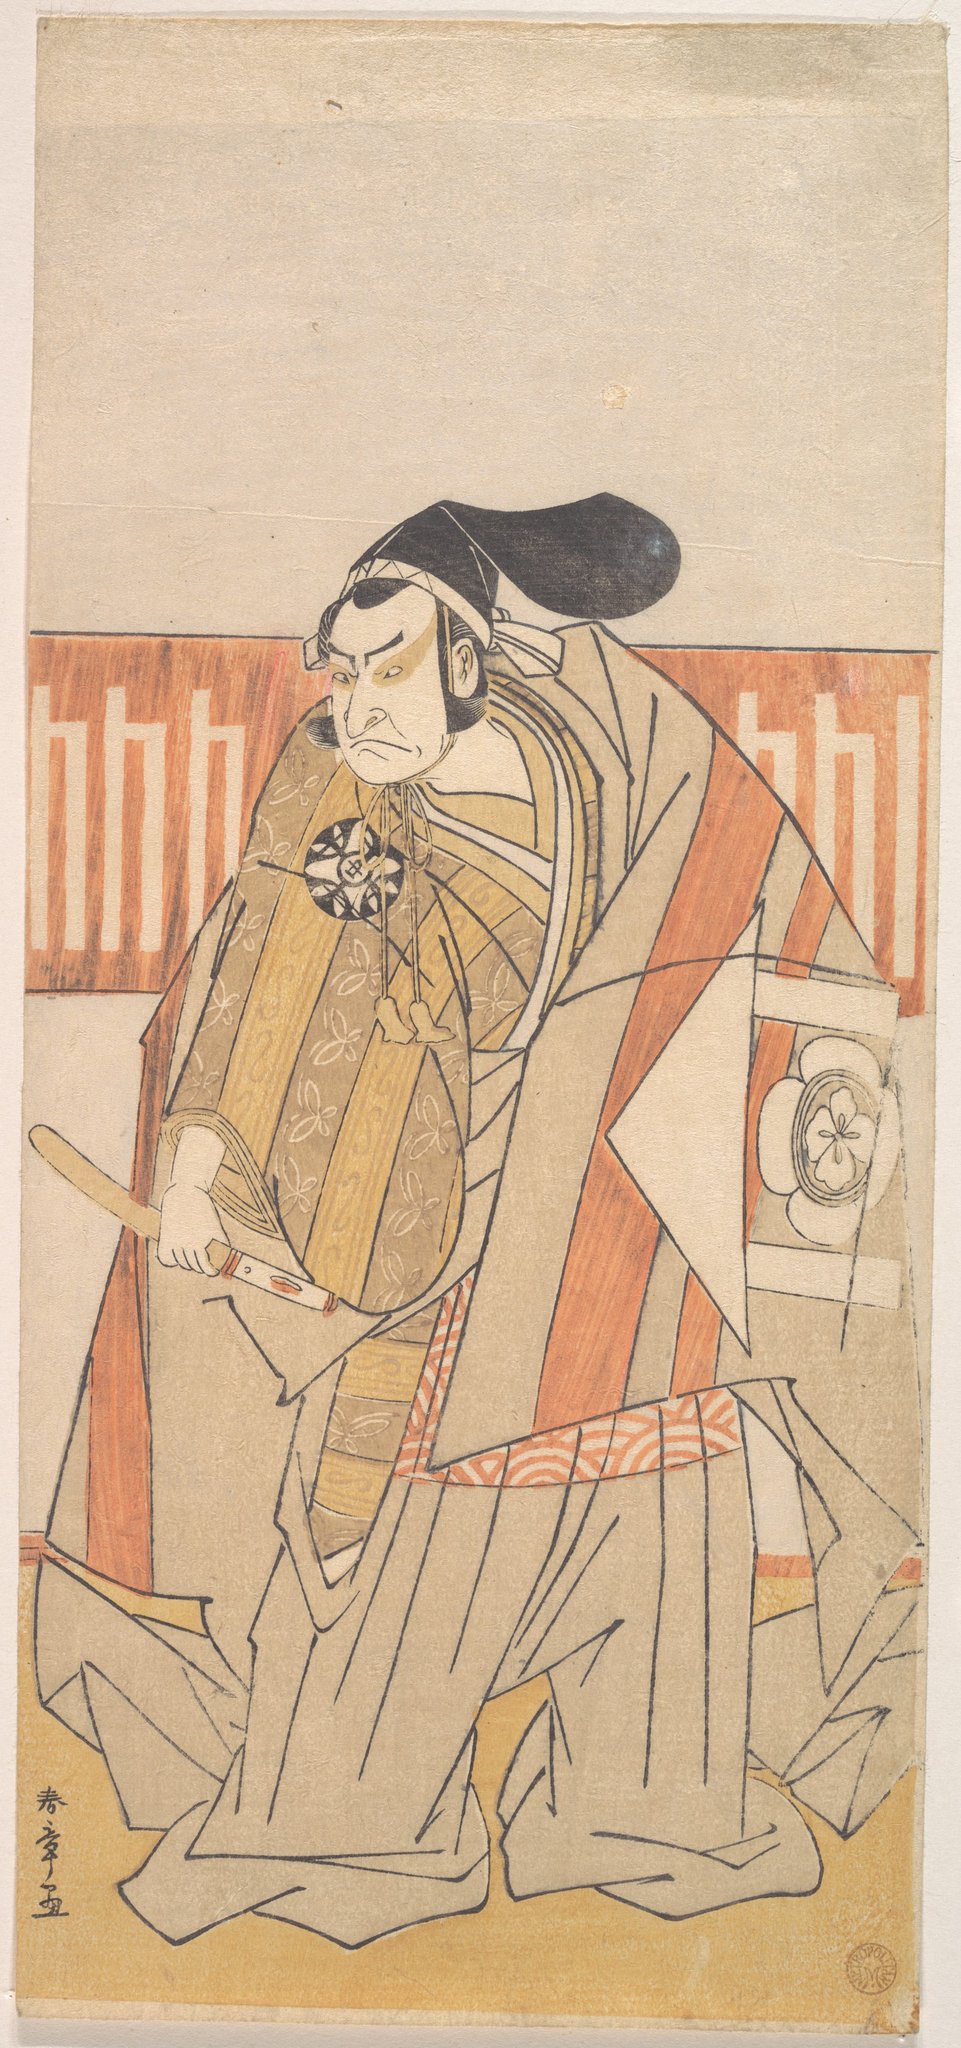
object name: woodblock print nishiki e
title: The First Nakamura Nakazo in the Role of Kudo Suketsune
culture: japanese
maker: katsukawa shunshō 勝川春章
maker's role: artist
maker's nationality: japanese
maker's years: 1726-1792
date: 1775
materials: ink, paper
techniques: nishiki e, woodblock print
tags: men,actors